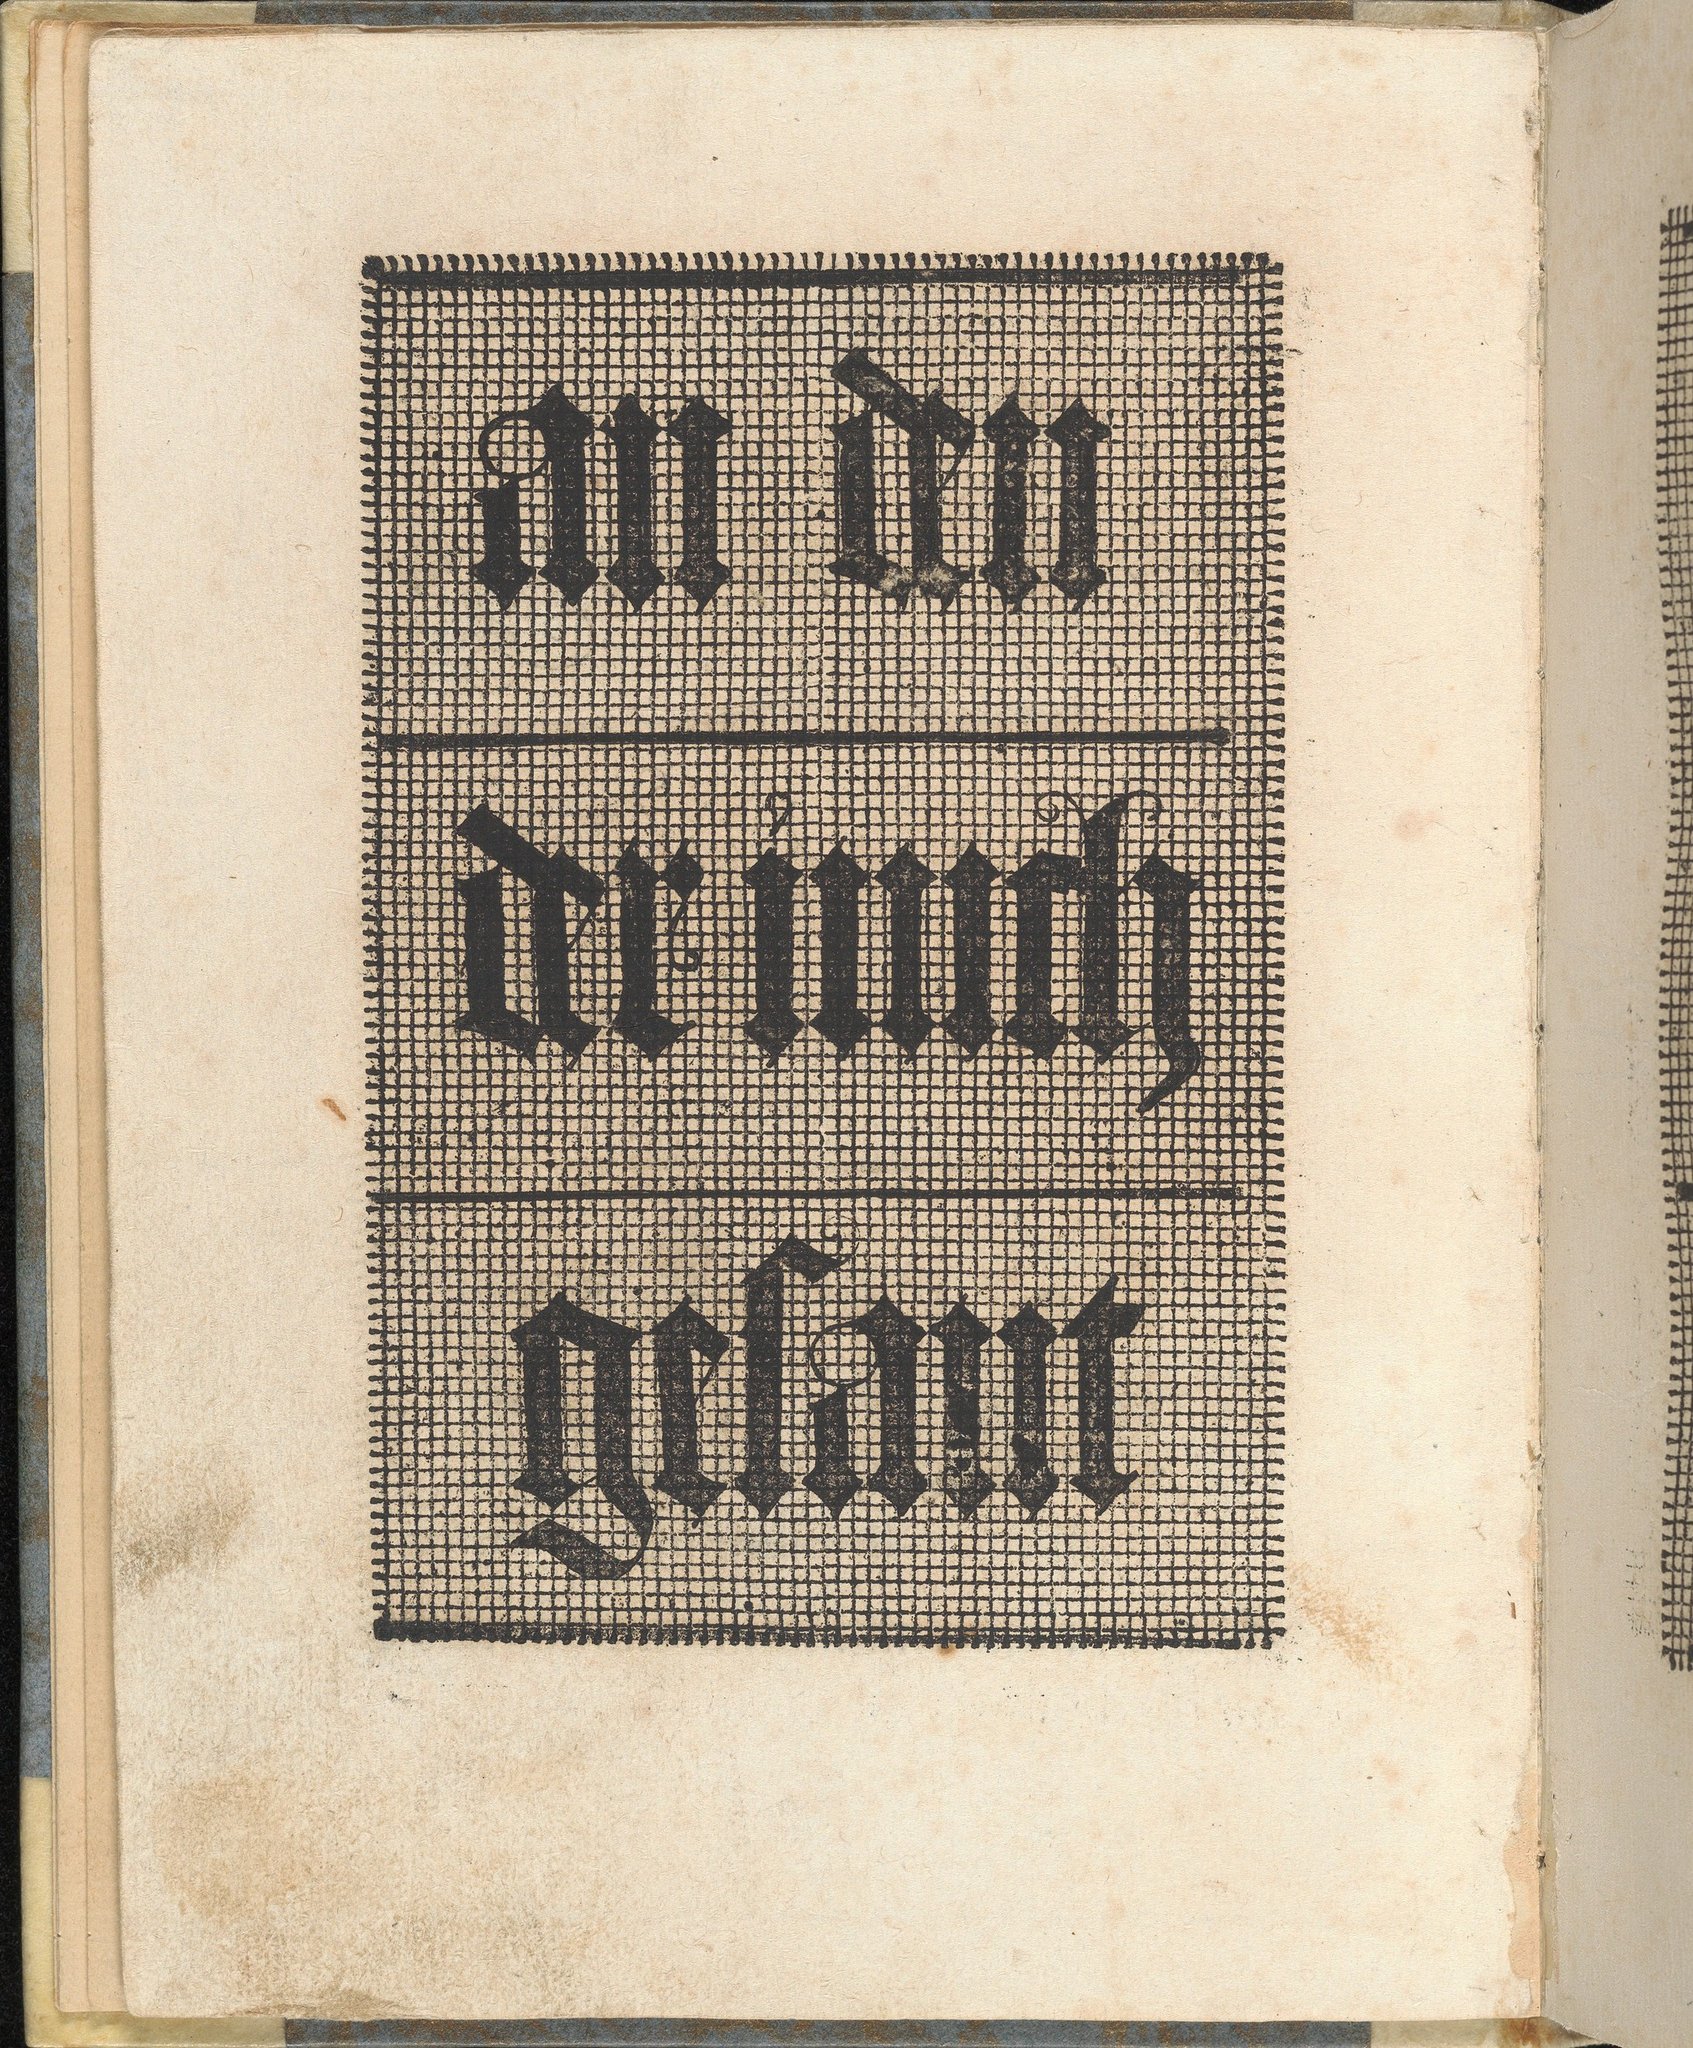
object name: book print ornament architecture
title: Ein ney Furmbüchlein, Page 9, verso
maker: johann schönsperger the younger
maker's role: publisher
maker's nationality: german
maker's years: 1490-1550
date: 1525-1529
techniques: woodcut